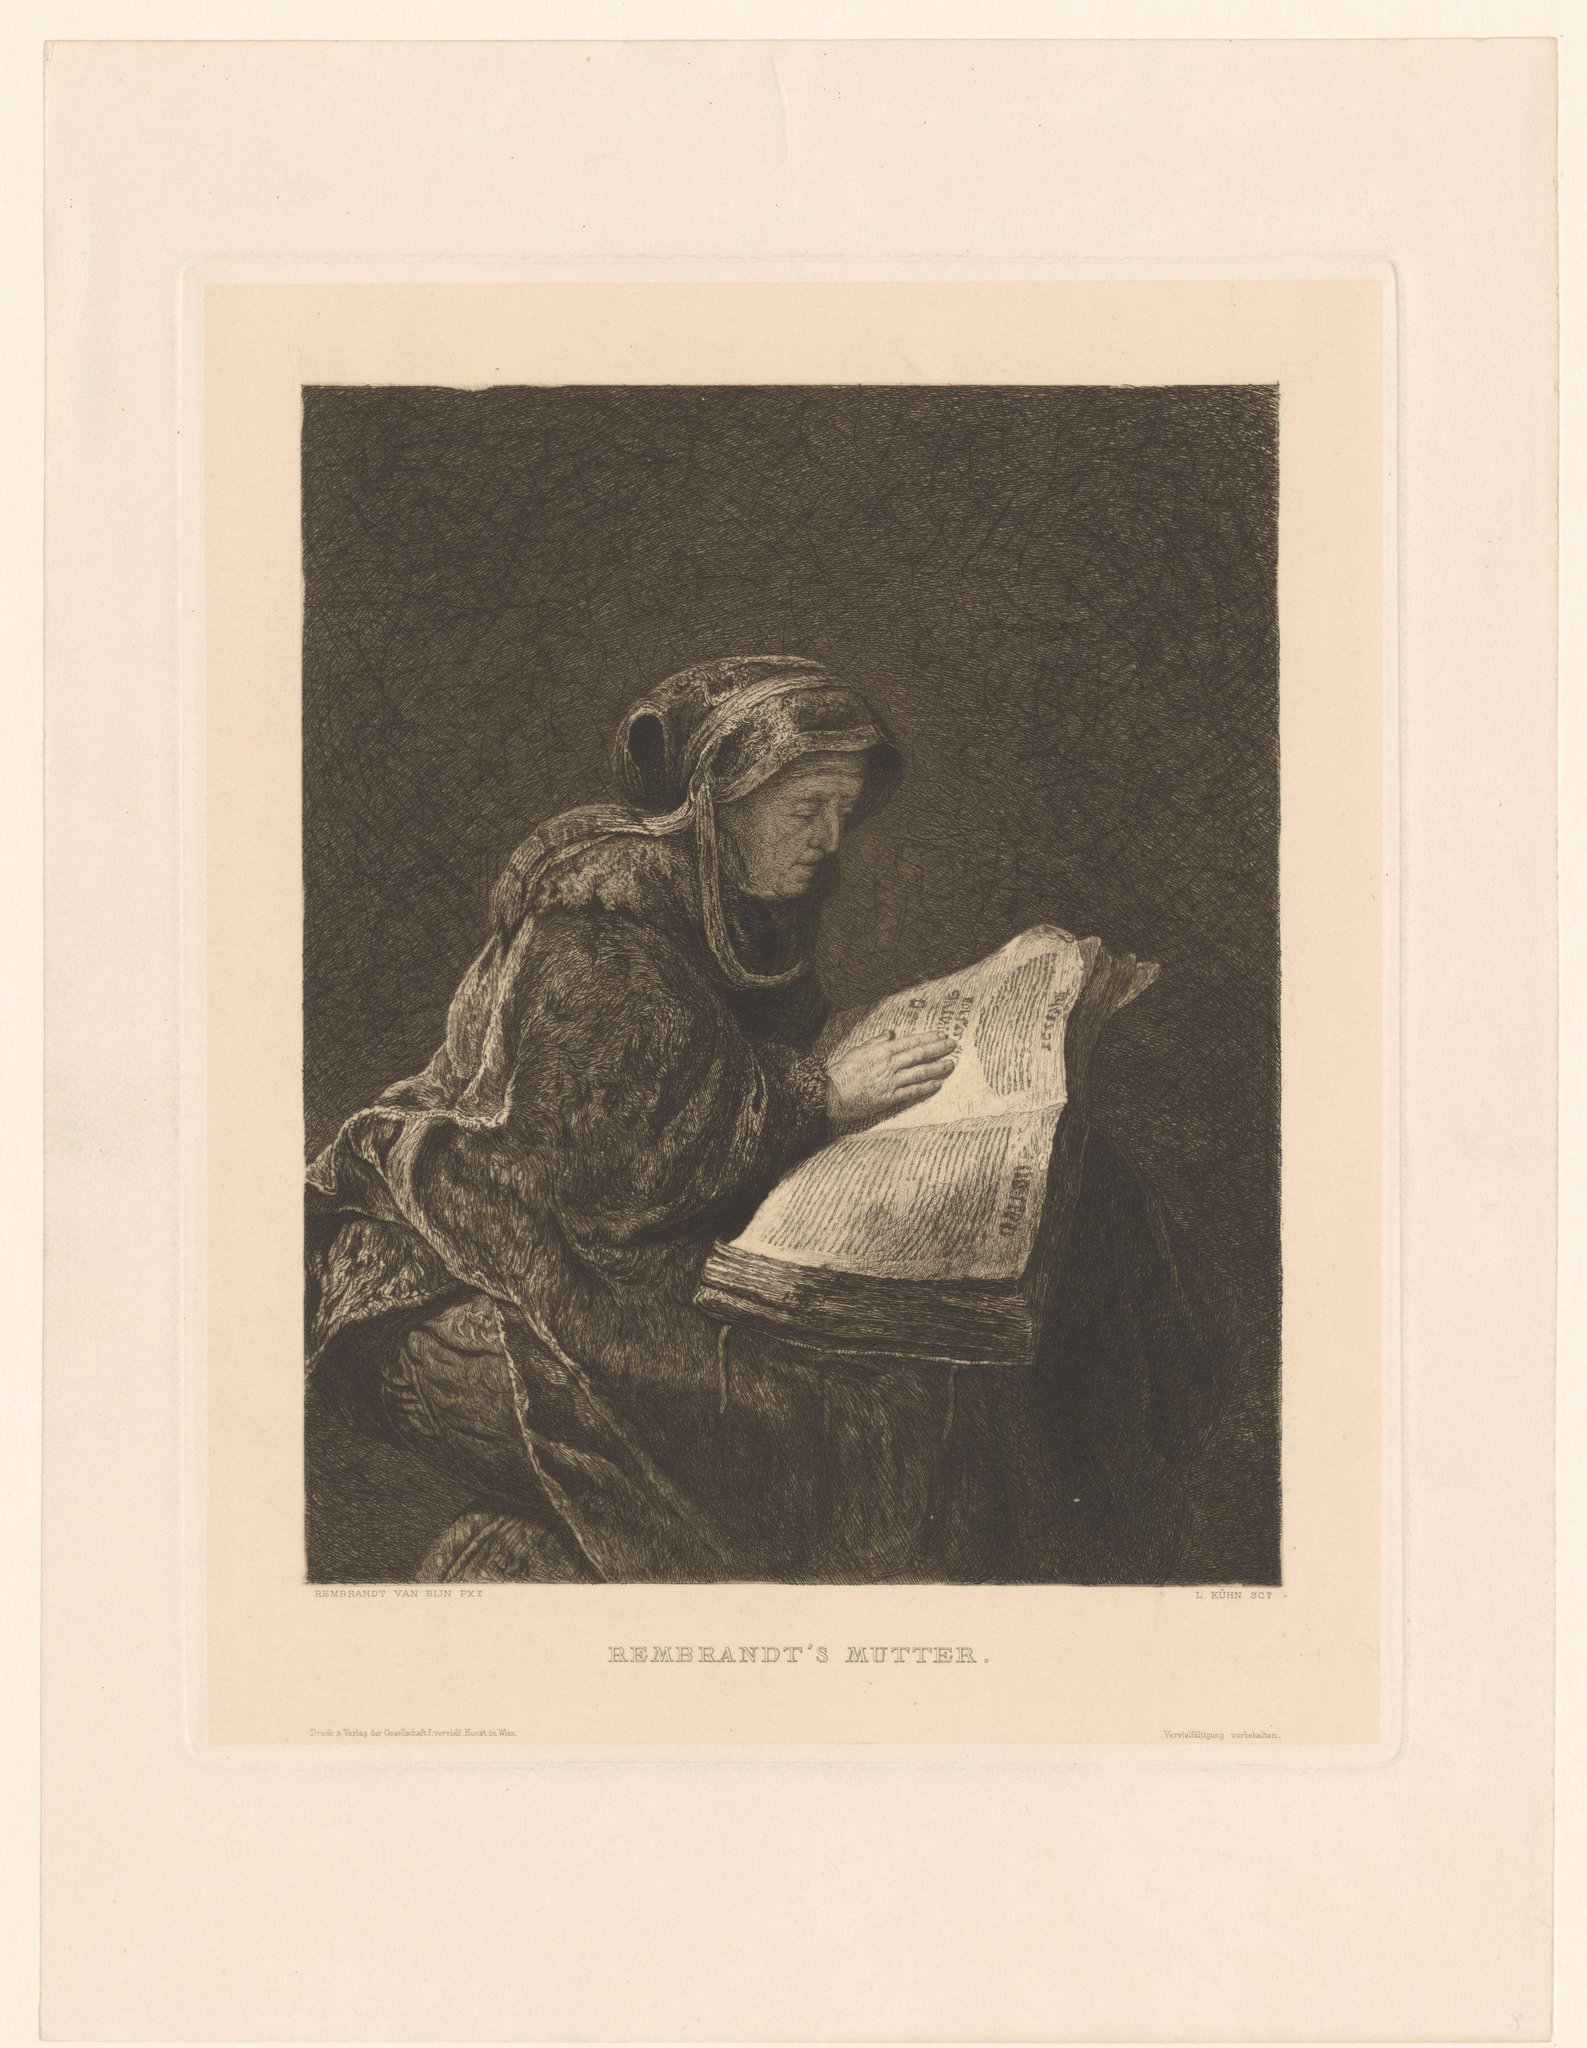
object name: print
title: Rembrandt's moeder lezend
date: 1871-1934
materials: paper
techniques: engraving, etching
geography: vienna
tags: old woman, book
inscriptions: collector's mark: Lugt 2228